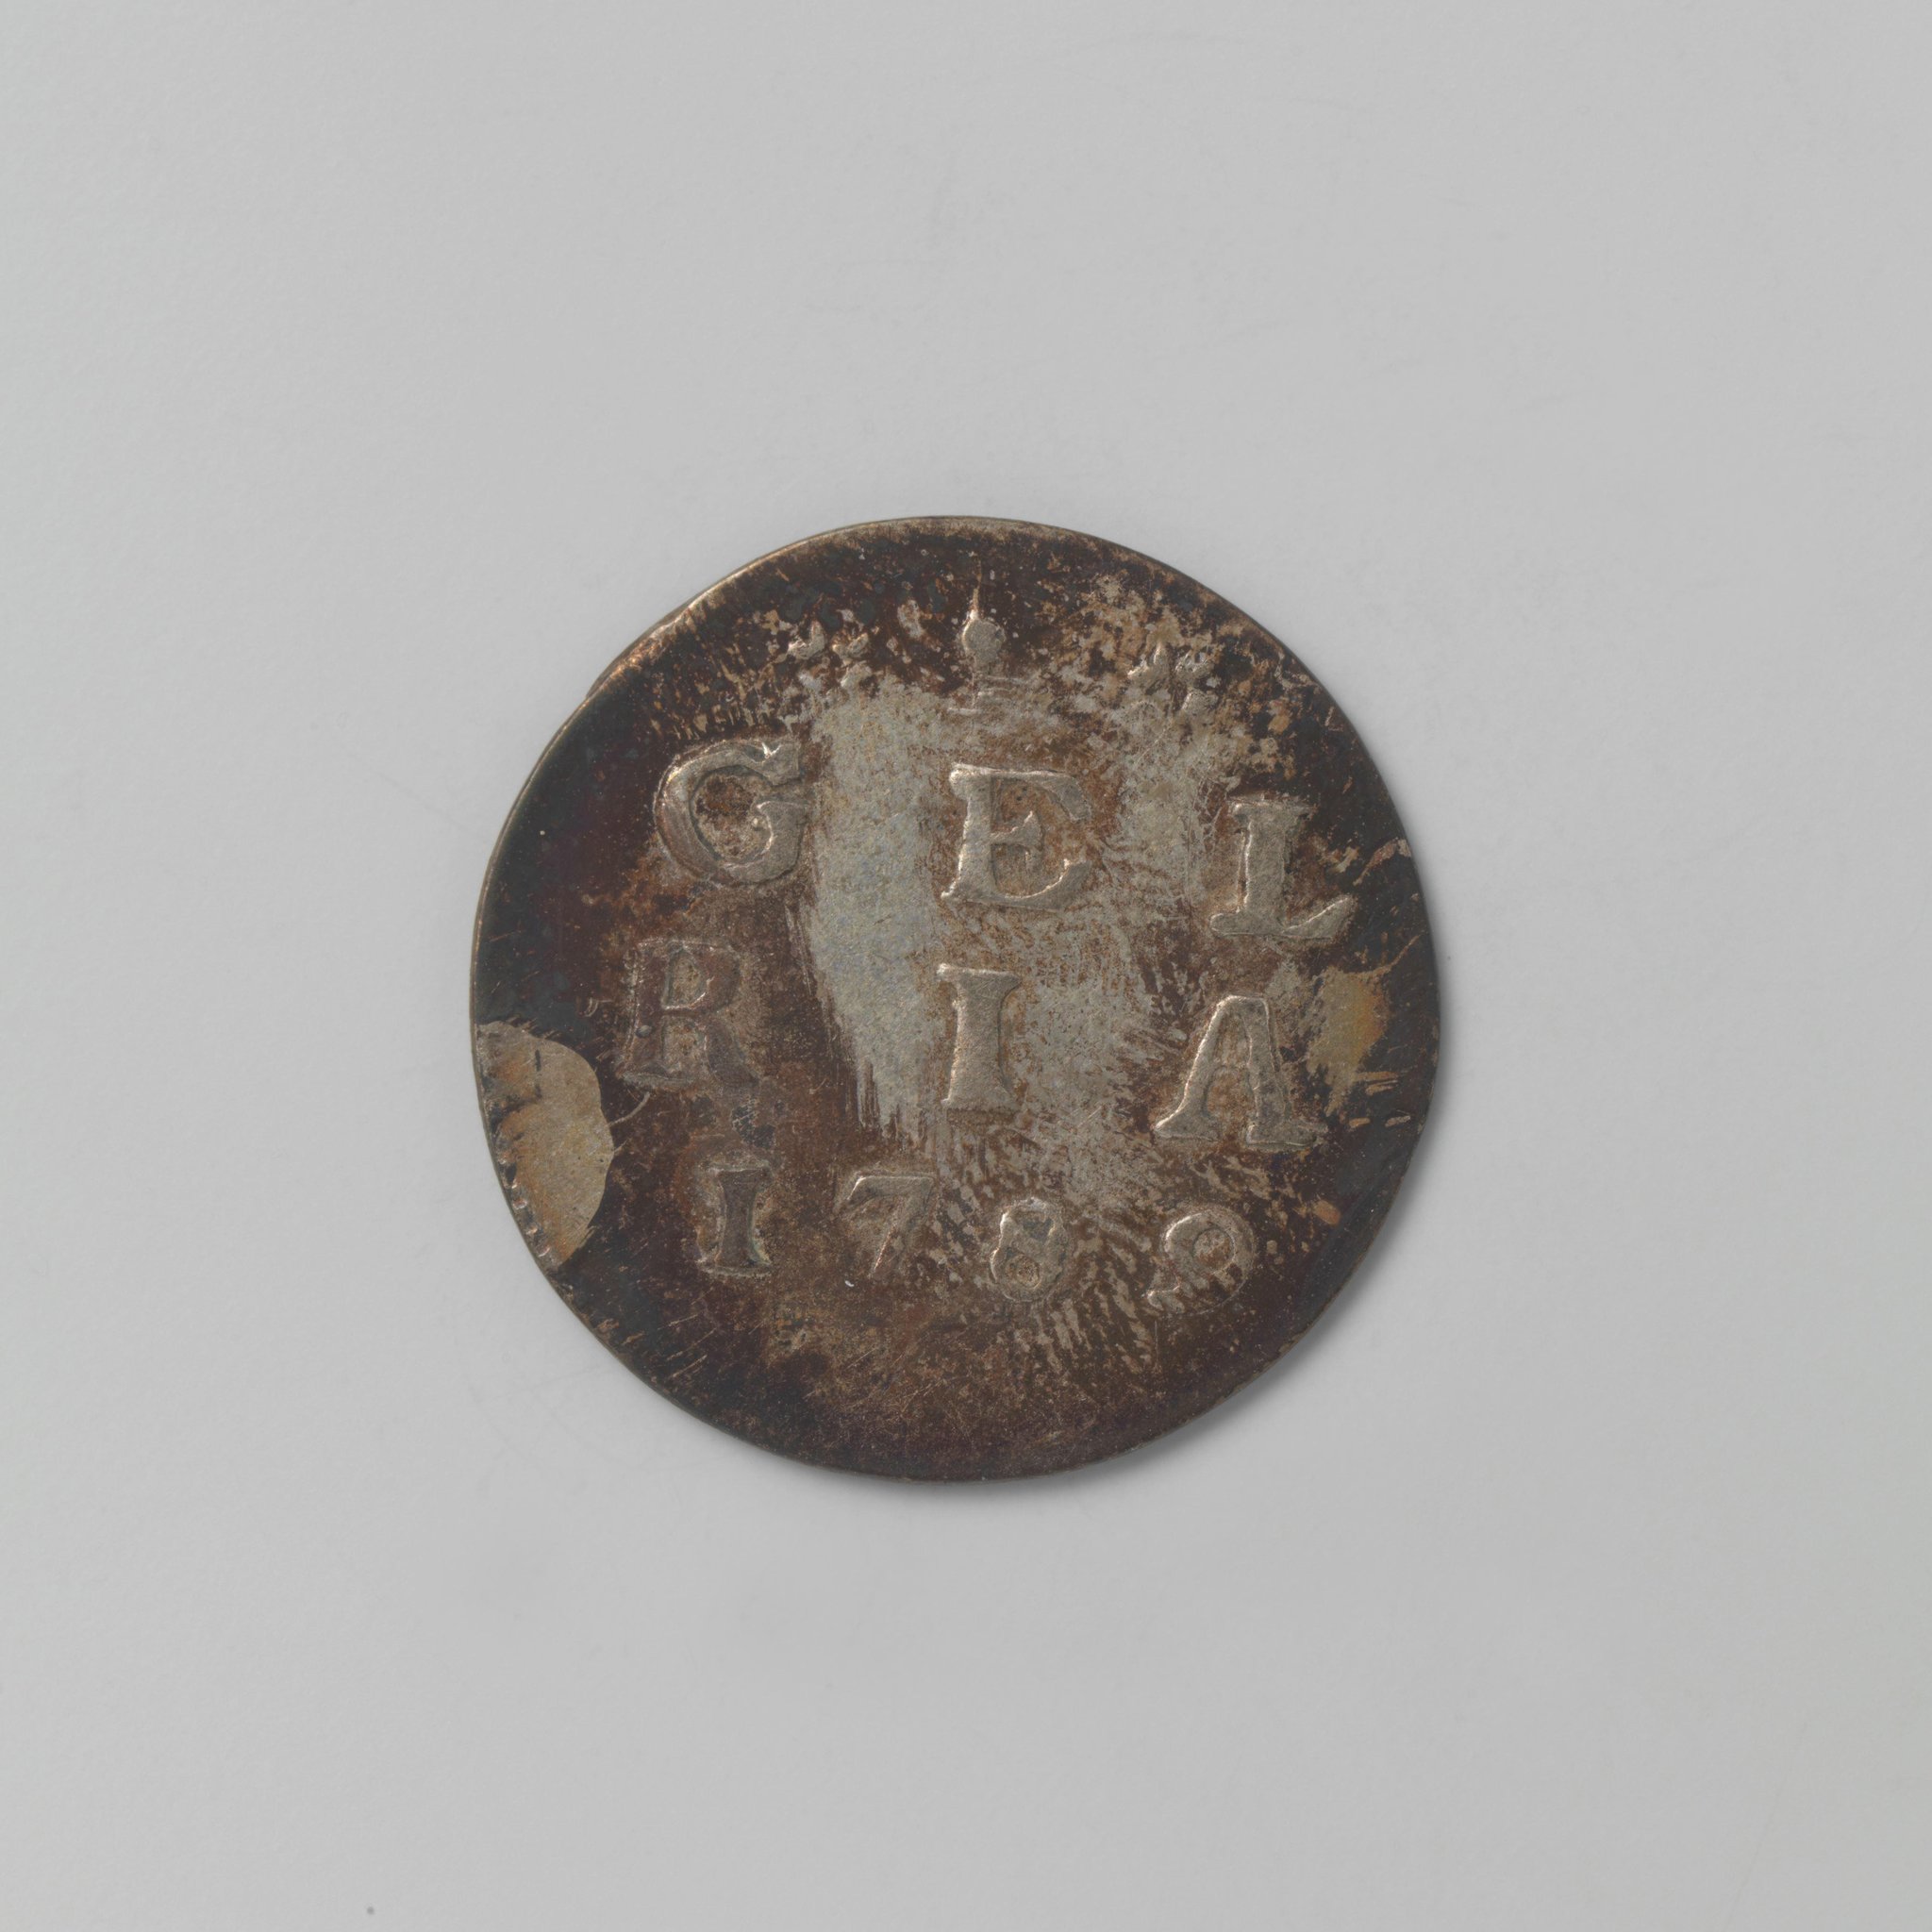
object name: coin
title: Gelderland, dubbele stuiver, 1789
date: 1789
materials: silver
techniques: striking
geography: harderwijk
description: Zilveren munt. Voorzijde: tussen waarde-aanduiding gekroond generaliteitswapenschild. Keerzijde: in twee regels tekst. Daaronder jaartal.